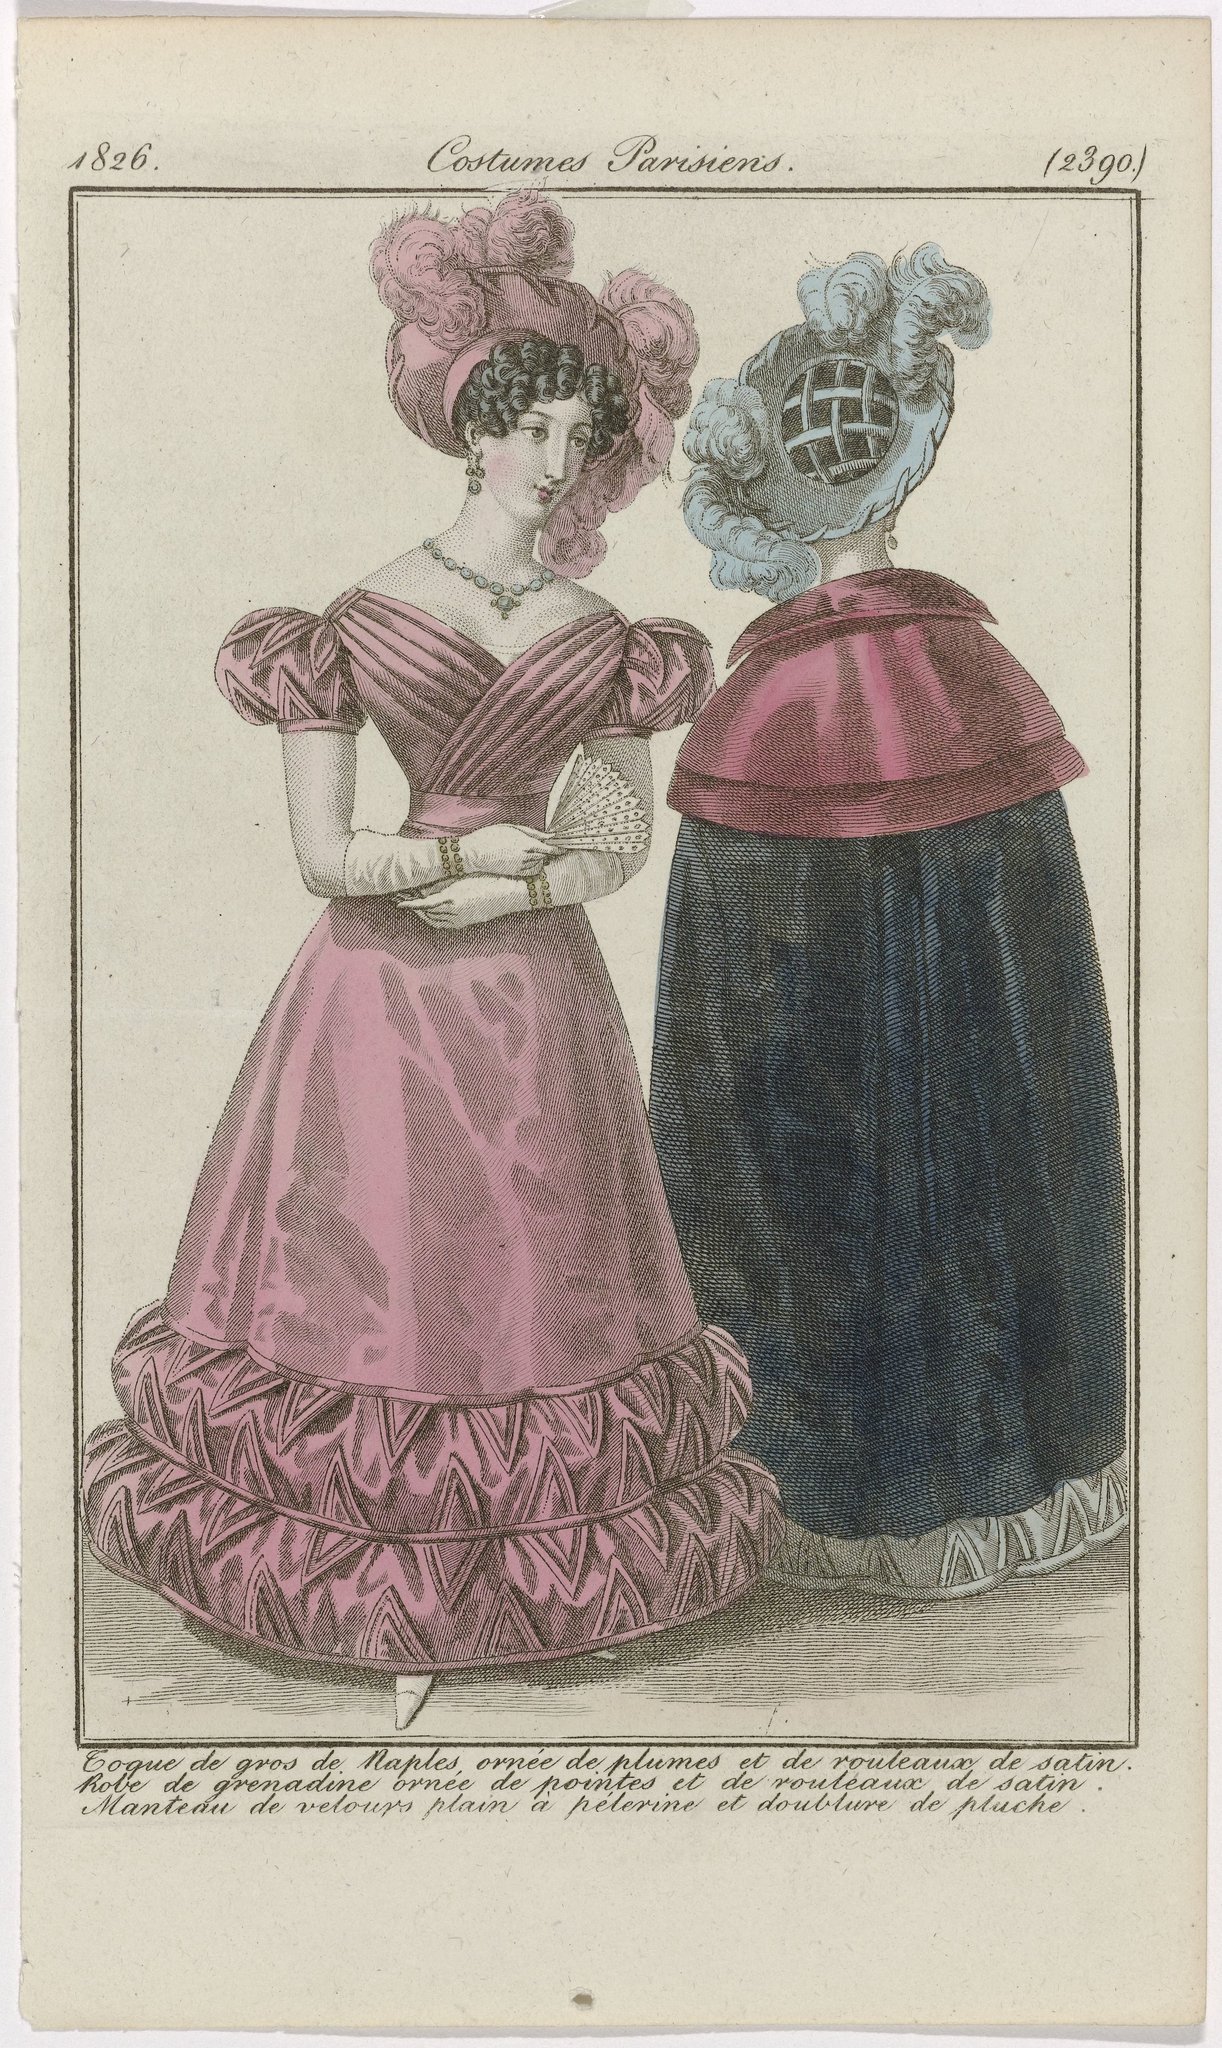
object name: fashion print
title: Journal des Dames et des Modes, Costumes Parisiens, 10 mars 1826, (2390): Toque de gros de Naples (...)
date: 1826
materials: paper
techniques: engraving, hand coloring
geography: paris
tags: ear-rings (+ women's clothes), head-gear: toque (+ women's clothes), ornamental parts of clothing (+ women's clothes), clothing for the upper part of the body (pelerine) (+ women's clothes), coat (+ women's clothes), fashion plates, gloves, mittens, etc. (+ women's clothes), dress, gown (+ women's clothes), fan (+ women's clothes), bracelet, wristlet (+ women's clothes), necklace (+ women's clothes)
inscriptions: caption: ‘Toque de gros de Naples, ornée de plumes et de rouleaux de satin. Robe de grenadine ornée de pointes et de rouleaux de satin. Manteau de velours plain à pélerine et doublure de pluche.’, title: ‘Costumes Parisiens.’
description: Vrouw met op het hoofd een 'toque' van 'gros de Naples', versierd met veren en een 'rouleaux' van satijn. Zij draagt een japon van 'grenadine', versierd met punten en 'rouleaux' van satijn. Verdere accessoires: oorbel in het rechteroor, collier, handschoenen, armbanden om beide polsen, waaier. Figuur in eenzelfde japon, op de rug gezien, met een mantel van 'velours plain' met pélerine en voering van pluche. De prent maakt deel uit van het modetijdschrift Journal des Dames et des Modes, uitgegeven door Pierre de la Mésangère, Parijs, 1797-1839.